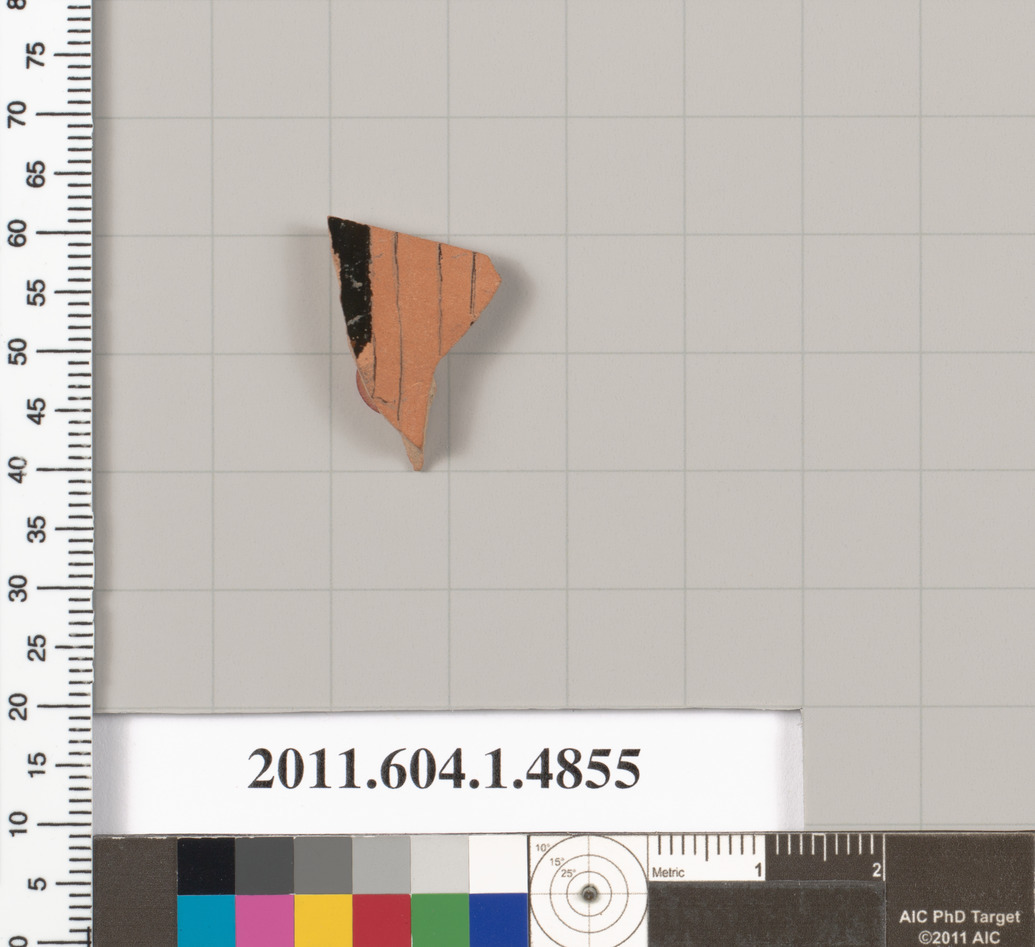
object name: kylix fragment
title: Terracotta fragment of a kylix (drinking cup)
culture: greek, attic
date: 475-451 BCE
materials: terracotta